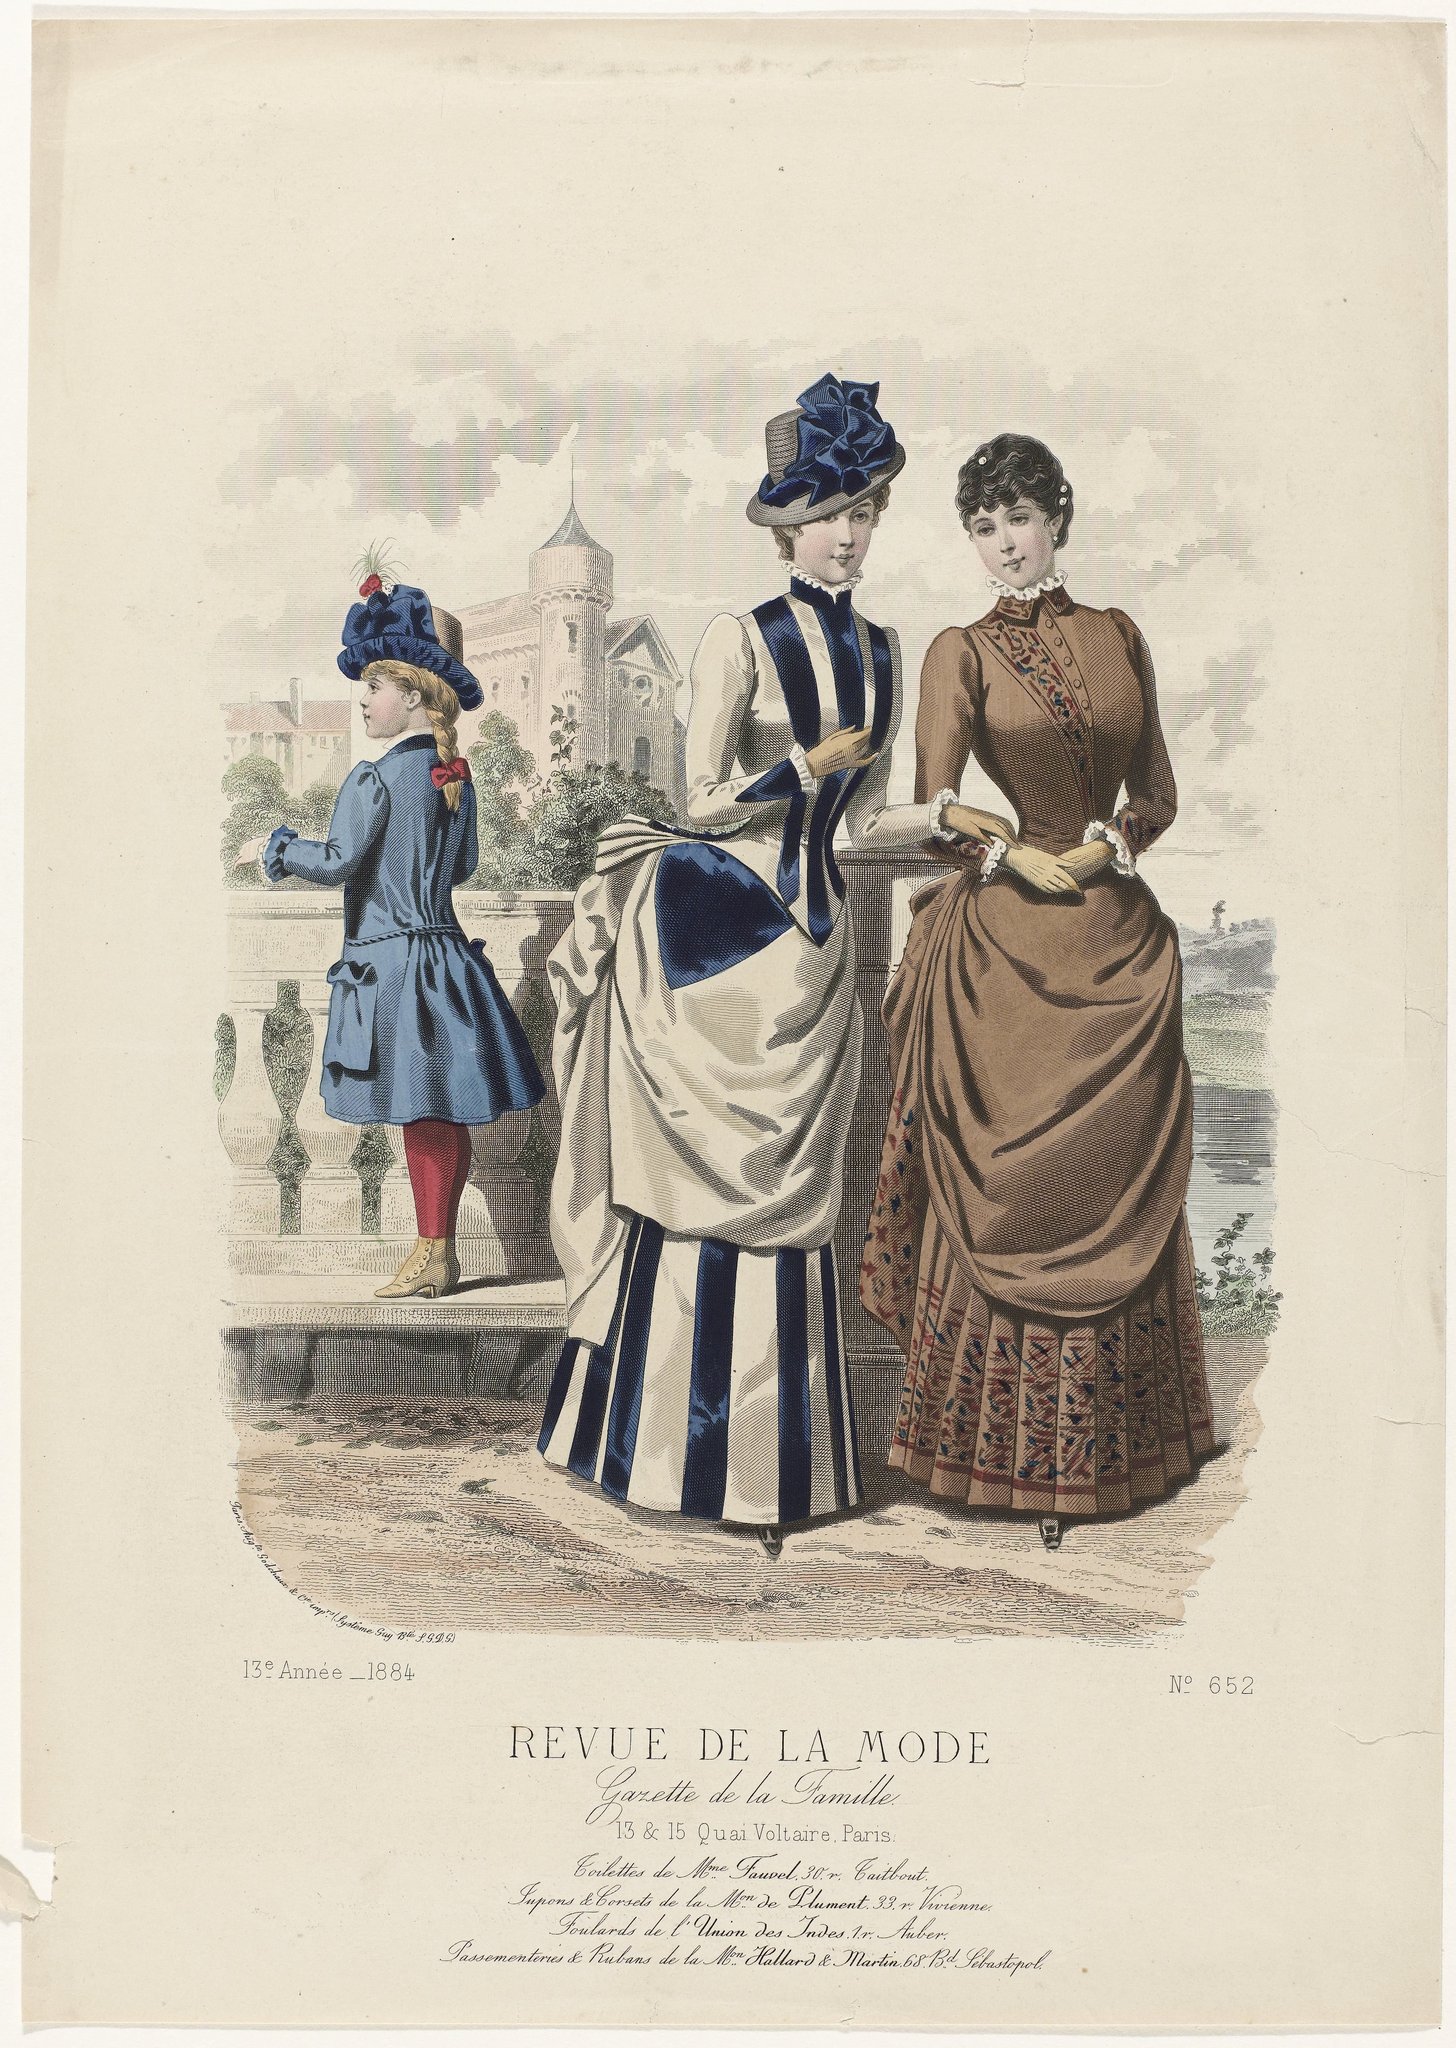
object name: fashion print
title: Revue de la Mode, Gazette de la Famille, dimanche 29 juin 1884, 13e Année, No. 652: Toilettes de Mme Fauvel (...)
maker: Anonymous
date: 1884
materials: paper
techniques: engraving, hand coloring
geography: paris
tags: clothing for the upper part of the body (+ women's clothes), head-gear: hat (+ girls' clothes), fashion plates, head-gear: hat (+ women's clothes), skirt (+ women's clothes), dress, gown (+ girls' clothes)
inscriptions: address: ‘13 & 15, Quai Voltaire Paris’, caption: ‘Toilettes de M.me Fauvel, 30, r. Taitbout. Jupons & Corsets de la M.on de Plument, 33, r. Vivienne. Foulards de l'Union des Indes, 1,r. Auber. Passementeries & Rubans de la M.on Hallard & Martin, 68, B.d Sébastopol.’, title: ‘REVUE DE LA MODE / Gazette de la Famille’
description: Twee vrouwen, in japonnen van Fauvel, en een meisje bij een balustrade. Kinderkleding voor een meisje van zes jaar van English Warehouse: 'robe-blouse' gefronseld bij de taille, met zakken en geplooide mouwen. Vrouw links: japon van écrukleurige 'étamine' gestreept met banden van blauw fluweel. Rechts: japon van bruine effen voile en bruine gebrocheerde voile. Met enkele regels reclametekst voor verschillende producten. Prent uit het modetijdschrift Revue de la Mode (1872-1913). Uitgebreide beschrijving van de kleding op pagina 204 "PLANCHE COLORIÉE".